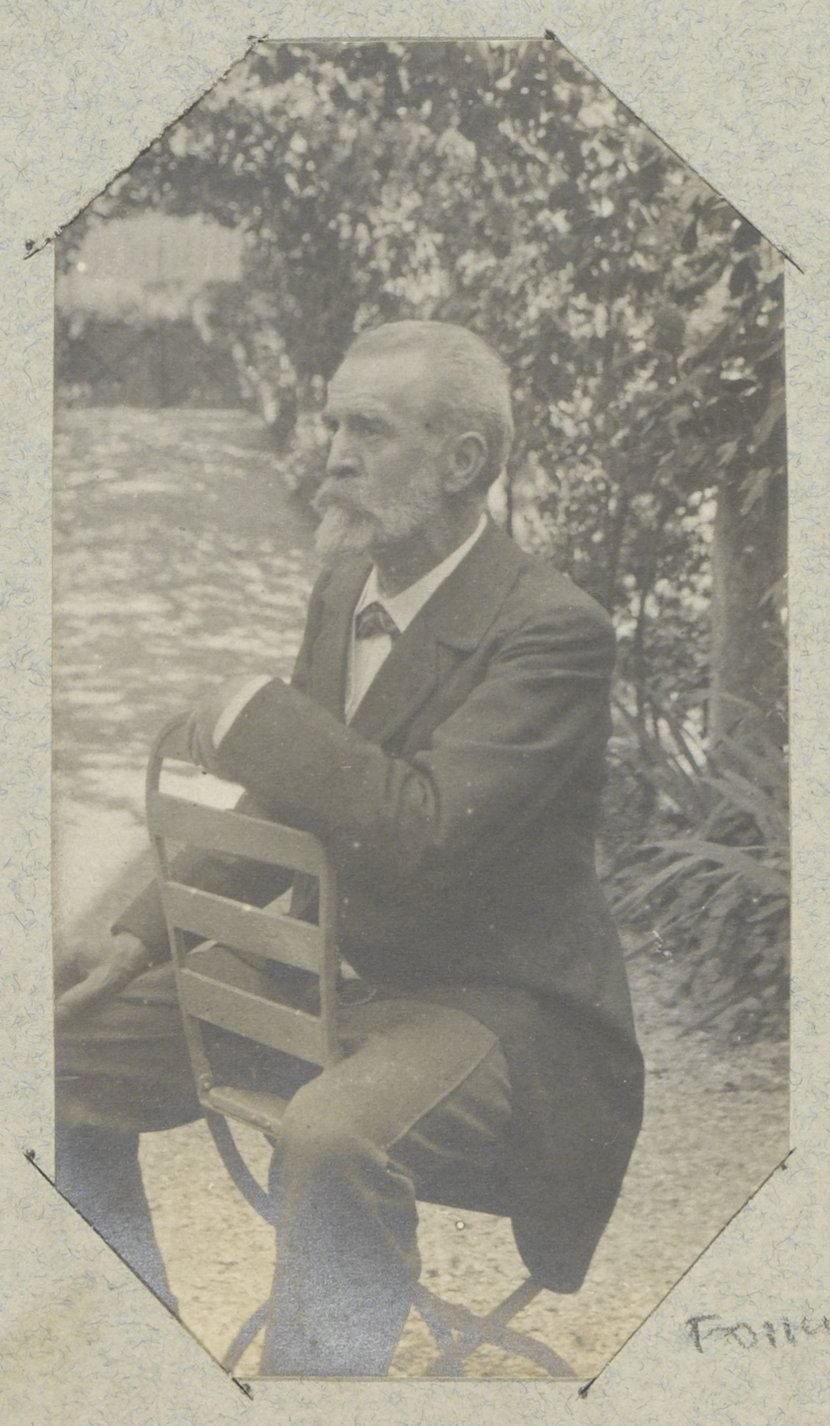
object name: photograph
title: Portret van een man met een baard, achterstevoren zittend op een stoel in de openlucht, vermoedelijk in Frankrijk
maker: Anonymous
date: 1890-1900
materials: paper, photographic support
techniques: gelatin silver print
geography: france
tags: sitting figure, adult man, chair, france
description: Onderdeel van Album van een Franse amateur met foto's van Frankrijk, Algerije, Palmyra, de Wereldtentoonstelling van 1900 en van bekende Fransen.